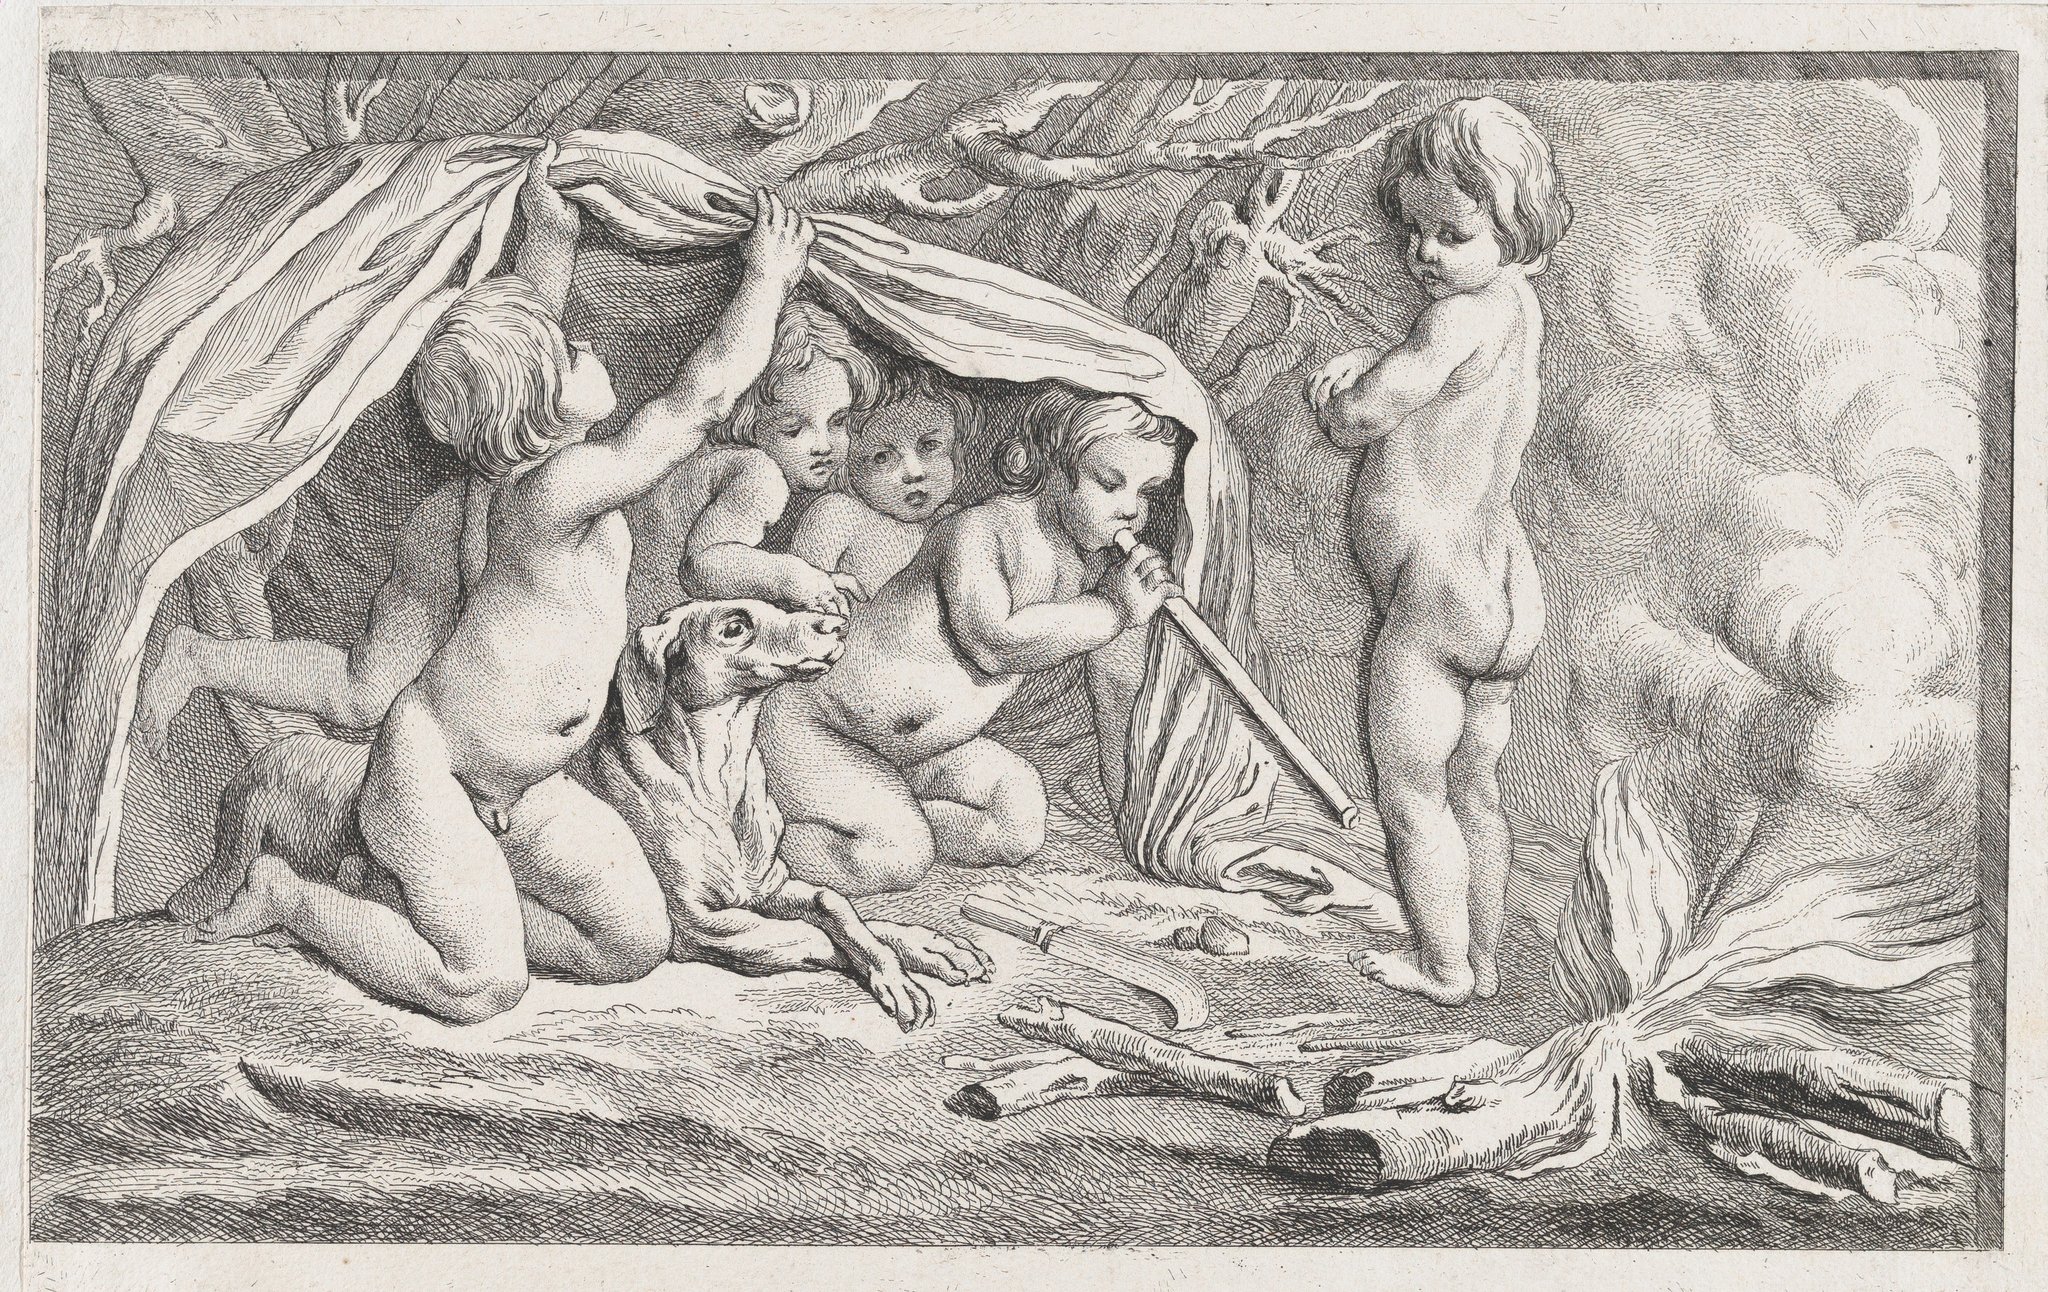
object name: print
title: Nude children and a dog warming themselves by a fire; an allegory of Winter, after a bas-relief on the Fontaine des Quatre-Saisons (Paris)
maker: Anonymous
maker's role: artist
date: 1745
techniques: etching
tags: children,dogs,fire